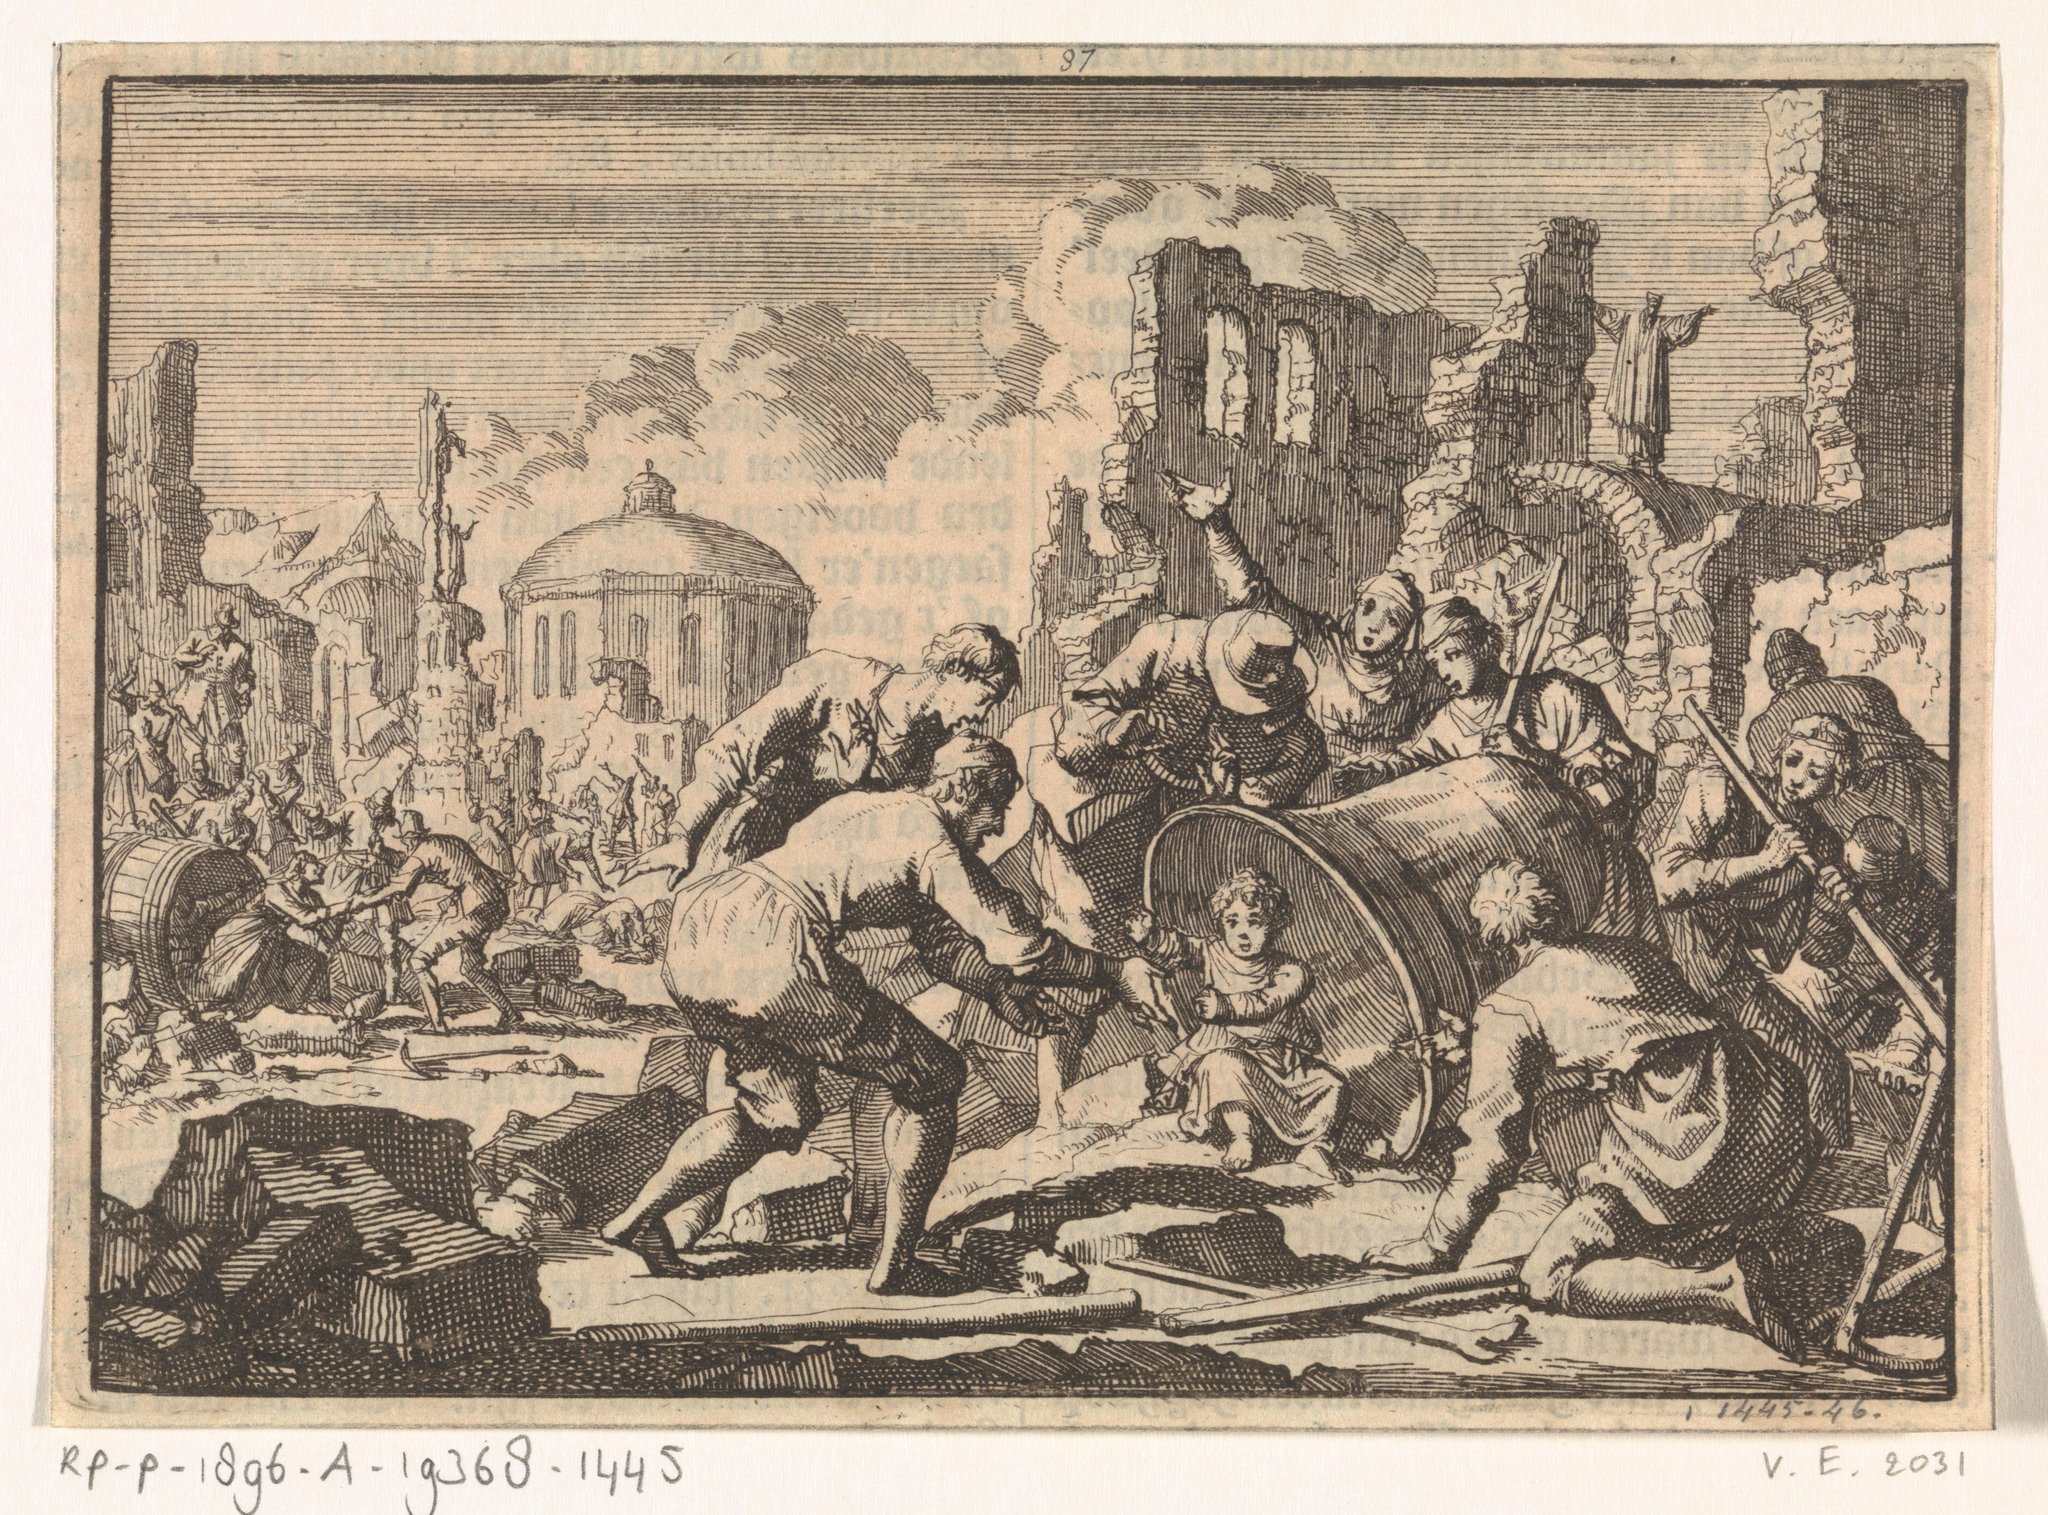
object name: print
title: Aardbeving te San Severo op Sicilië, 1627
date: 1698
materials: paper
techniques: etching, letterpress printing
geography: leiden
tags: earthquake, san severo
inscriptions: collector's mark: Lugt 2228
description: Illustratie uit: Gottfried, Johann Ludwig. Historische kronyck; vervattende een (...) beschrijvingh der aldergedenckwaerdigste geschiedenissen des weerelds, van den aenvangh der scheppingh tot (...) 1576 (2 delen). Leiden: Pieter van der Aa, 1698, dl. I, p. 1445.